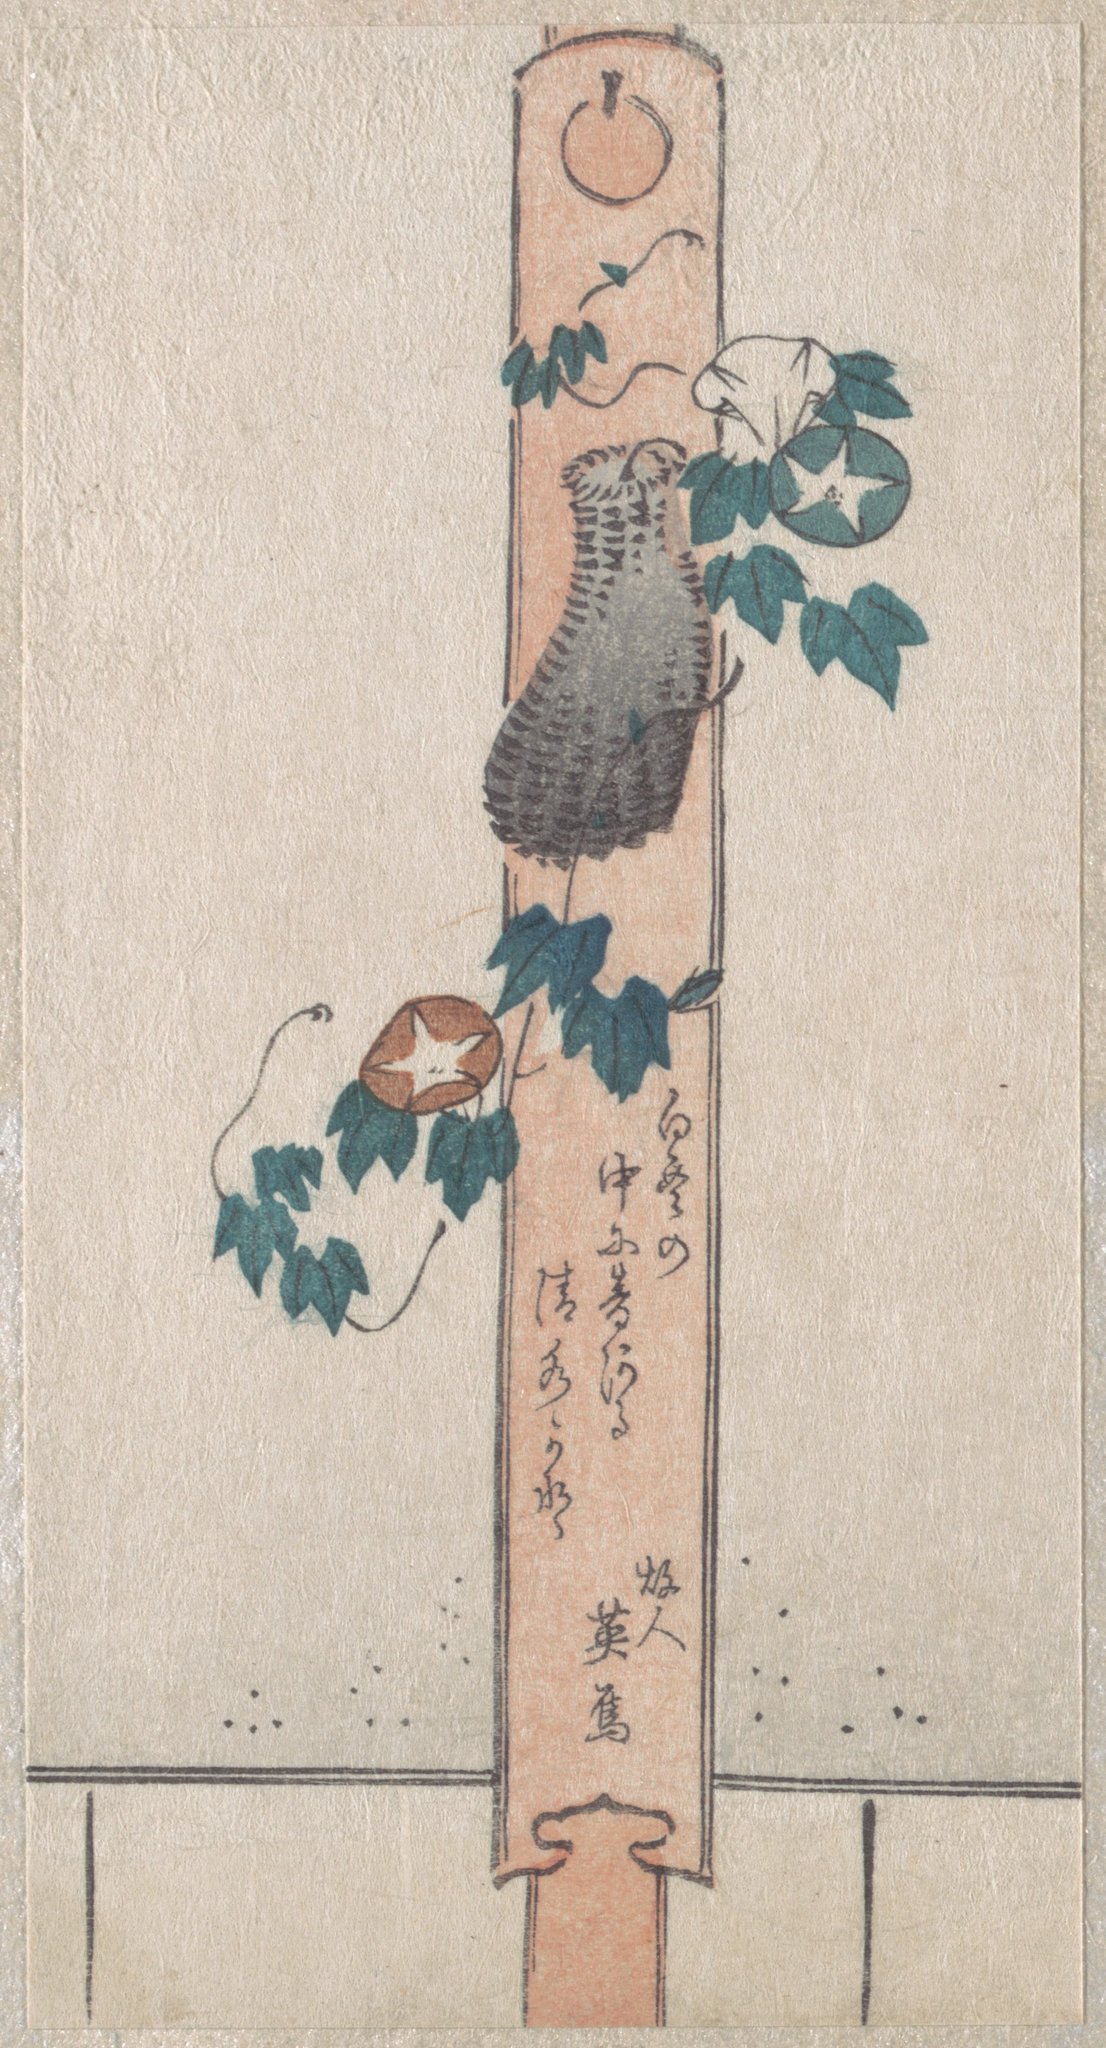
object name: print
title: Pillar Print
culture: japanese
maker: unidentified artist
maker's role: artist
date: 1701-1900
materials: ink, paper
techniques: surimono, woodblock print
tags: leaves